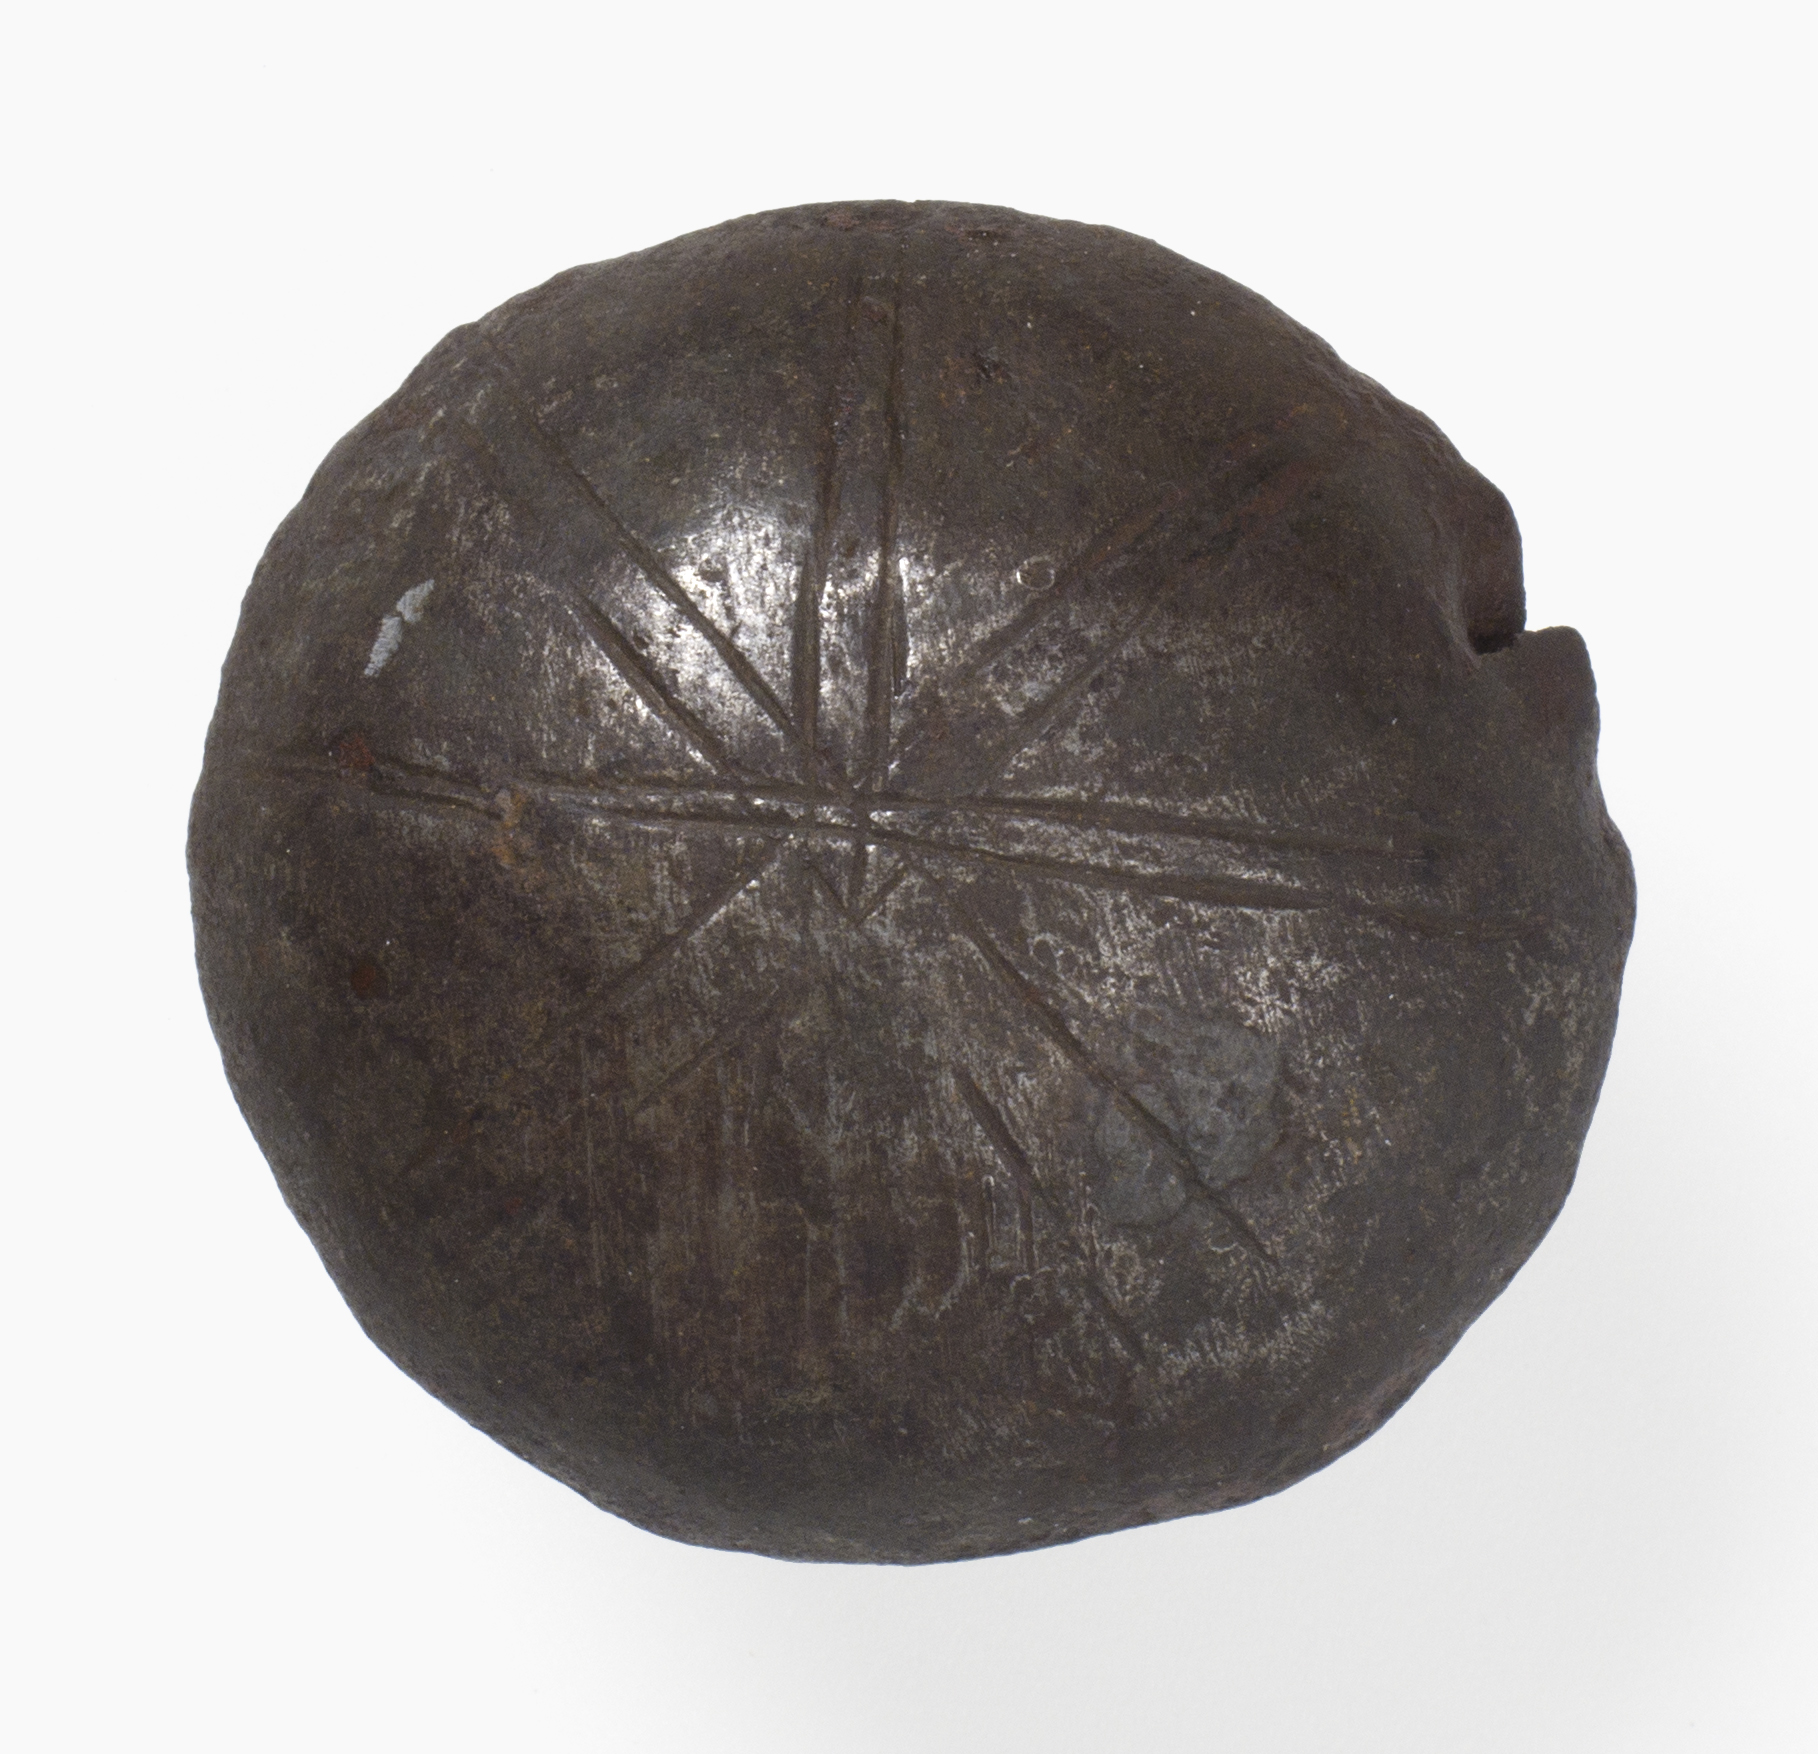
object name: nail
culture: european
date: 1401-1600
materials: iron